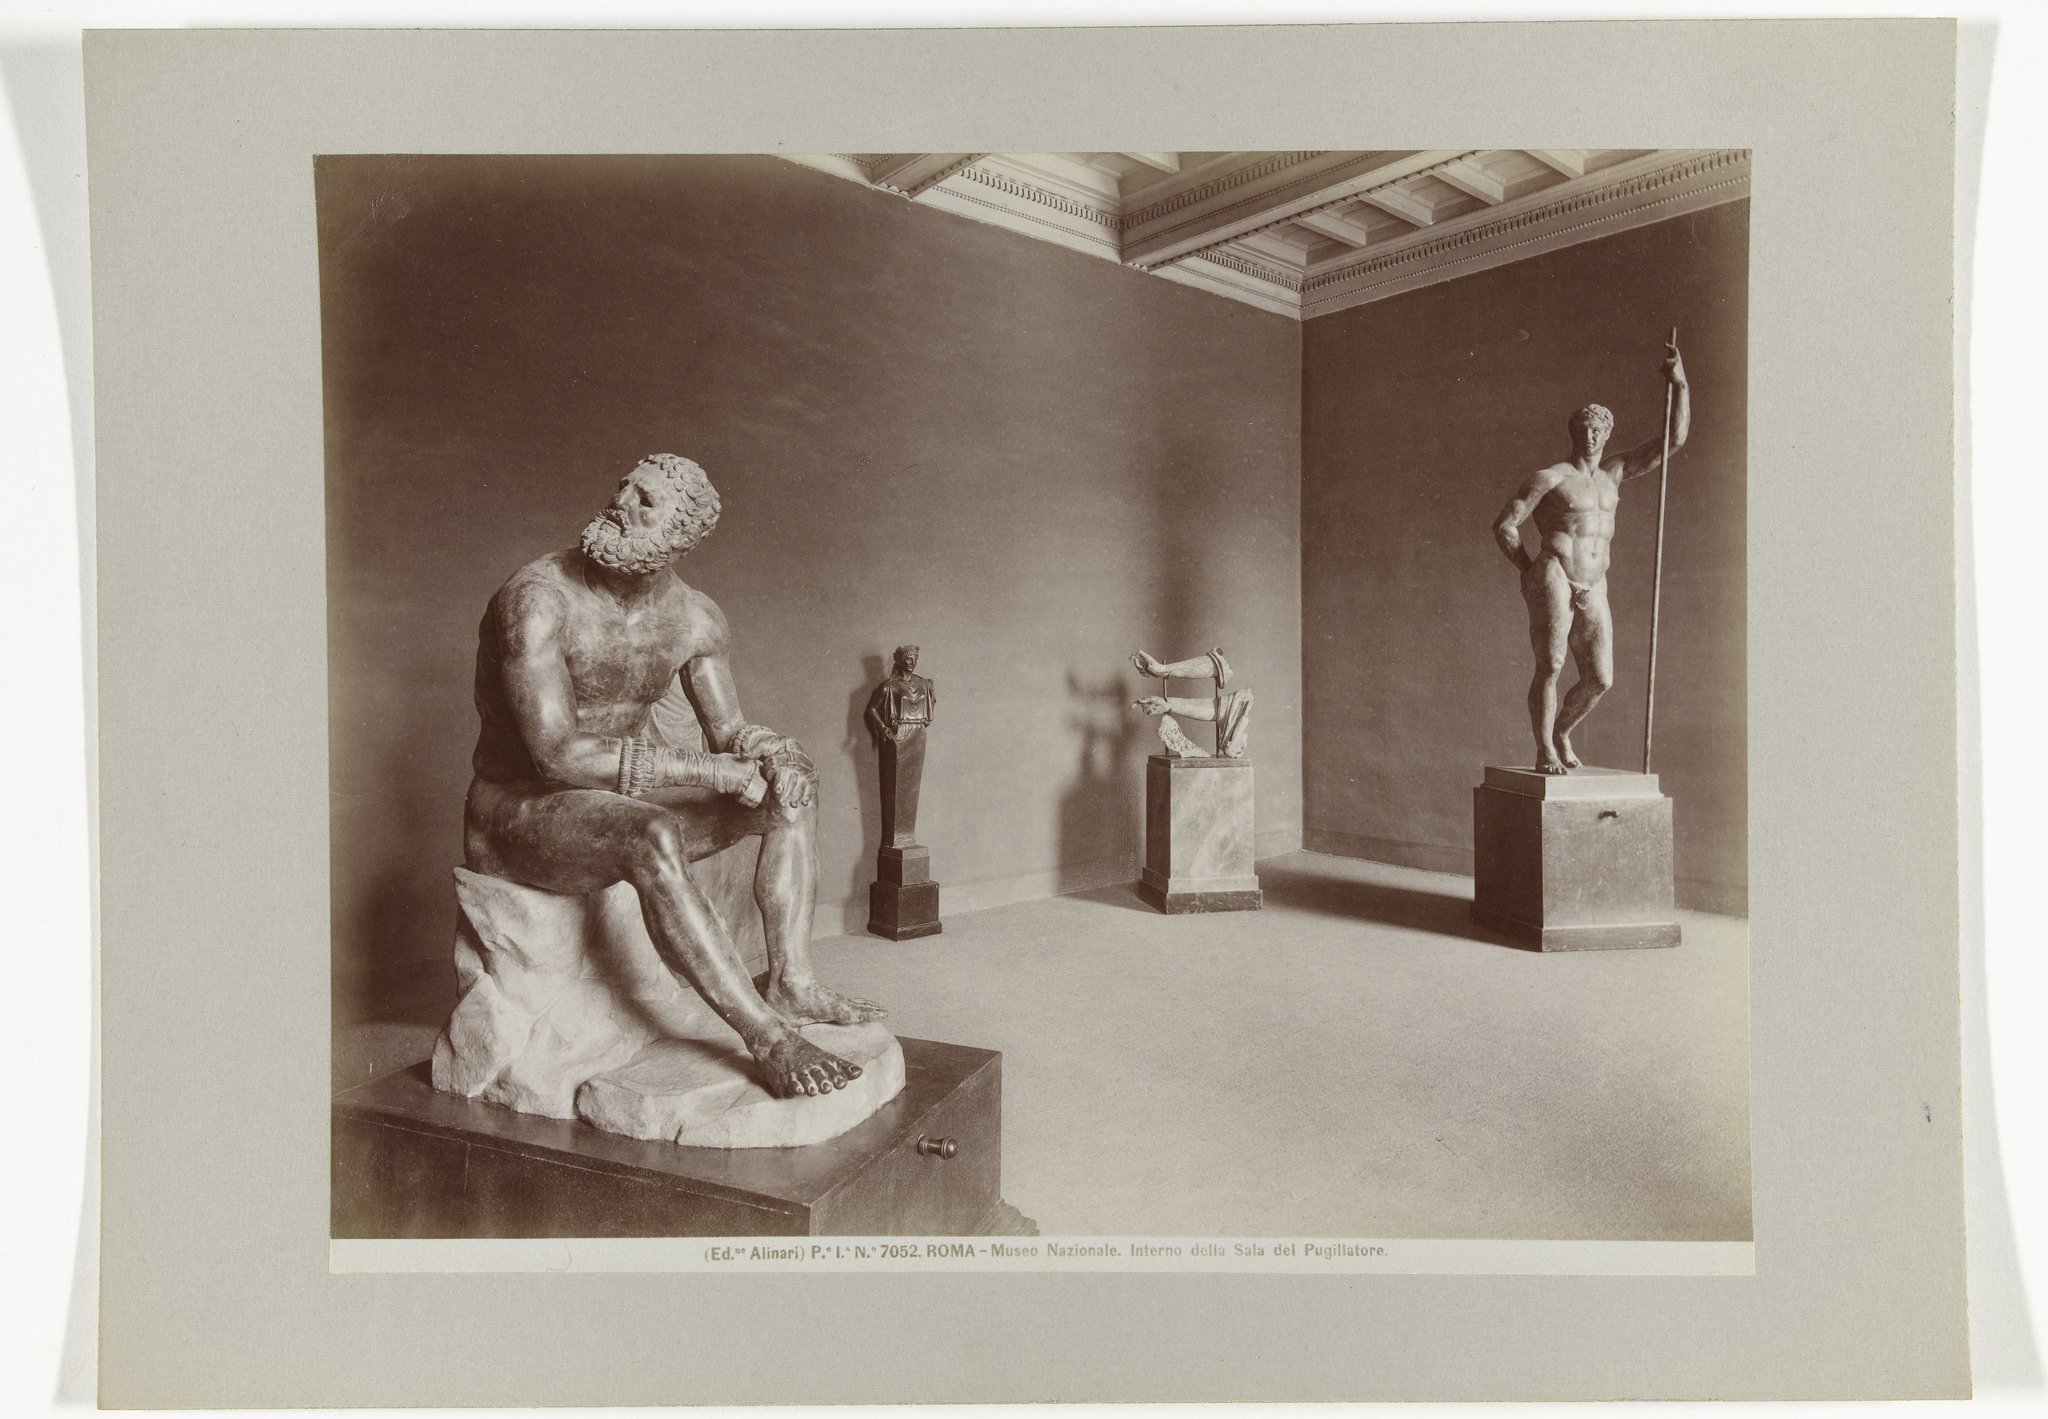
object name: photograph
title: P.e 1.a N.o 7052. ROMA - Museo Nazionale. Interno della Sala del Pugillatore.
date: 1880-1895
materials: cardboard, paper, photographic support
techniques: albumen print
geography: florence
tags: piece of sculpture, reproduction of a piece of sculpture, permanent exhibition, museum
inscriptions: number: ‘6.’